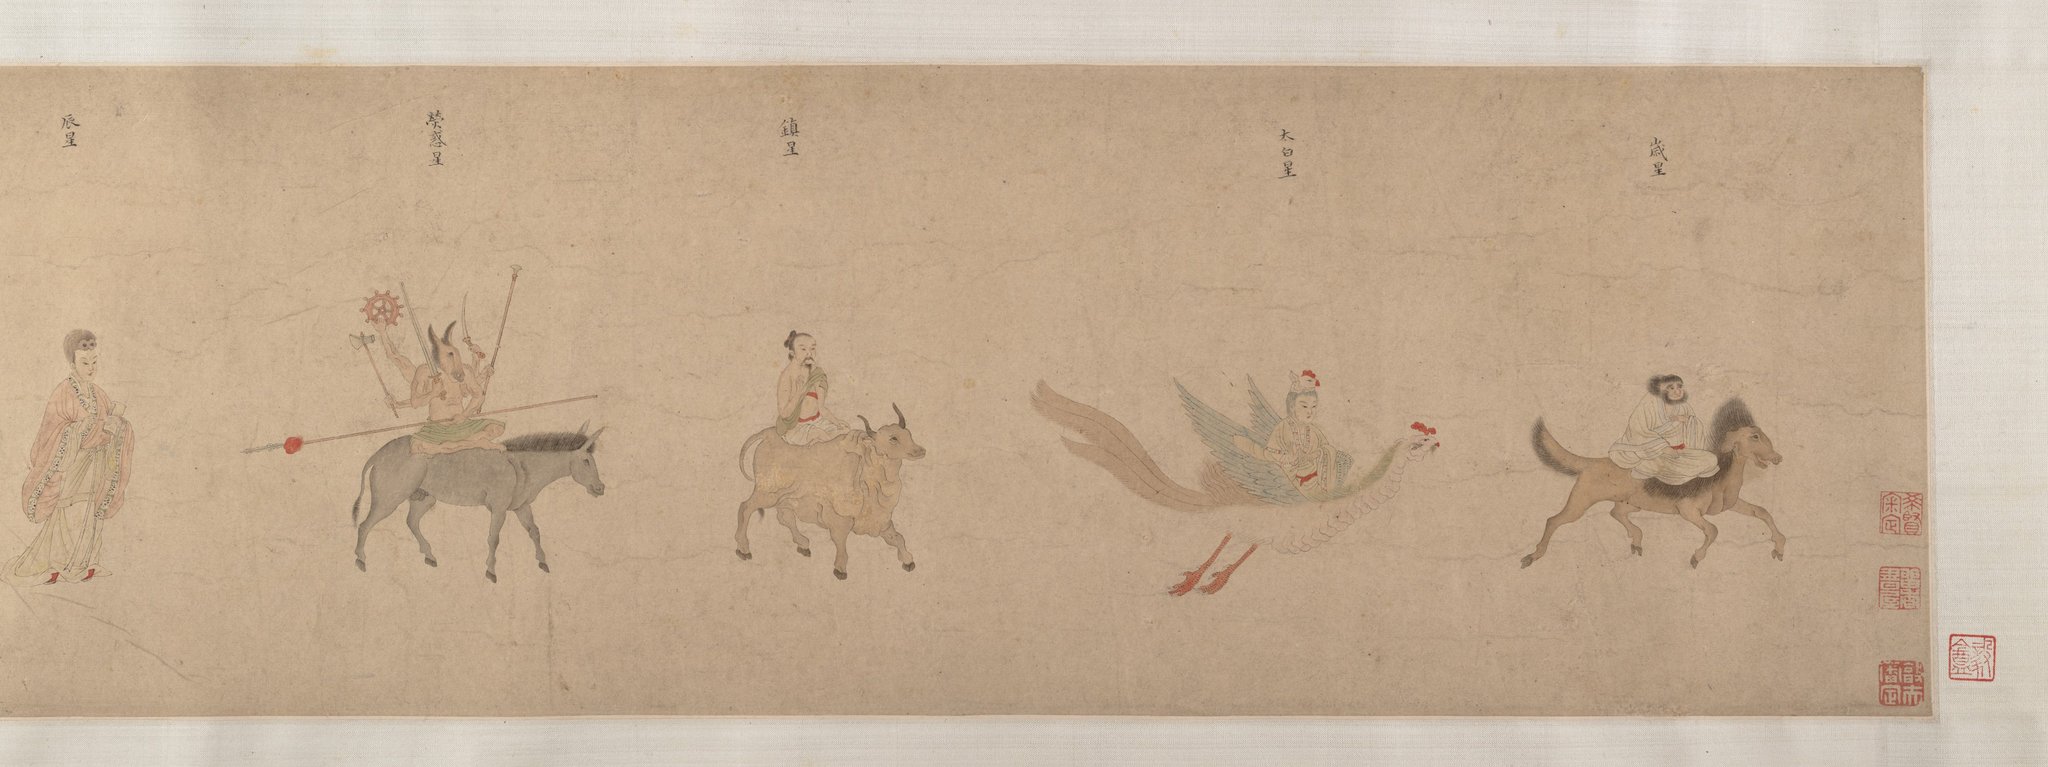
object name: handscroll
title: Divinities of the Planets and Constellations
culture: chinese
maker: qiu ying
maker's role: artist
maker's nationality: chinese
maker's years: 1485-1562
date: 1501-1600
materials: ink, paper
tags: birds,men,horses